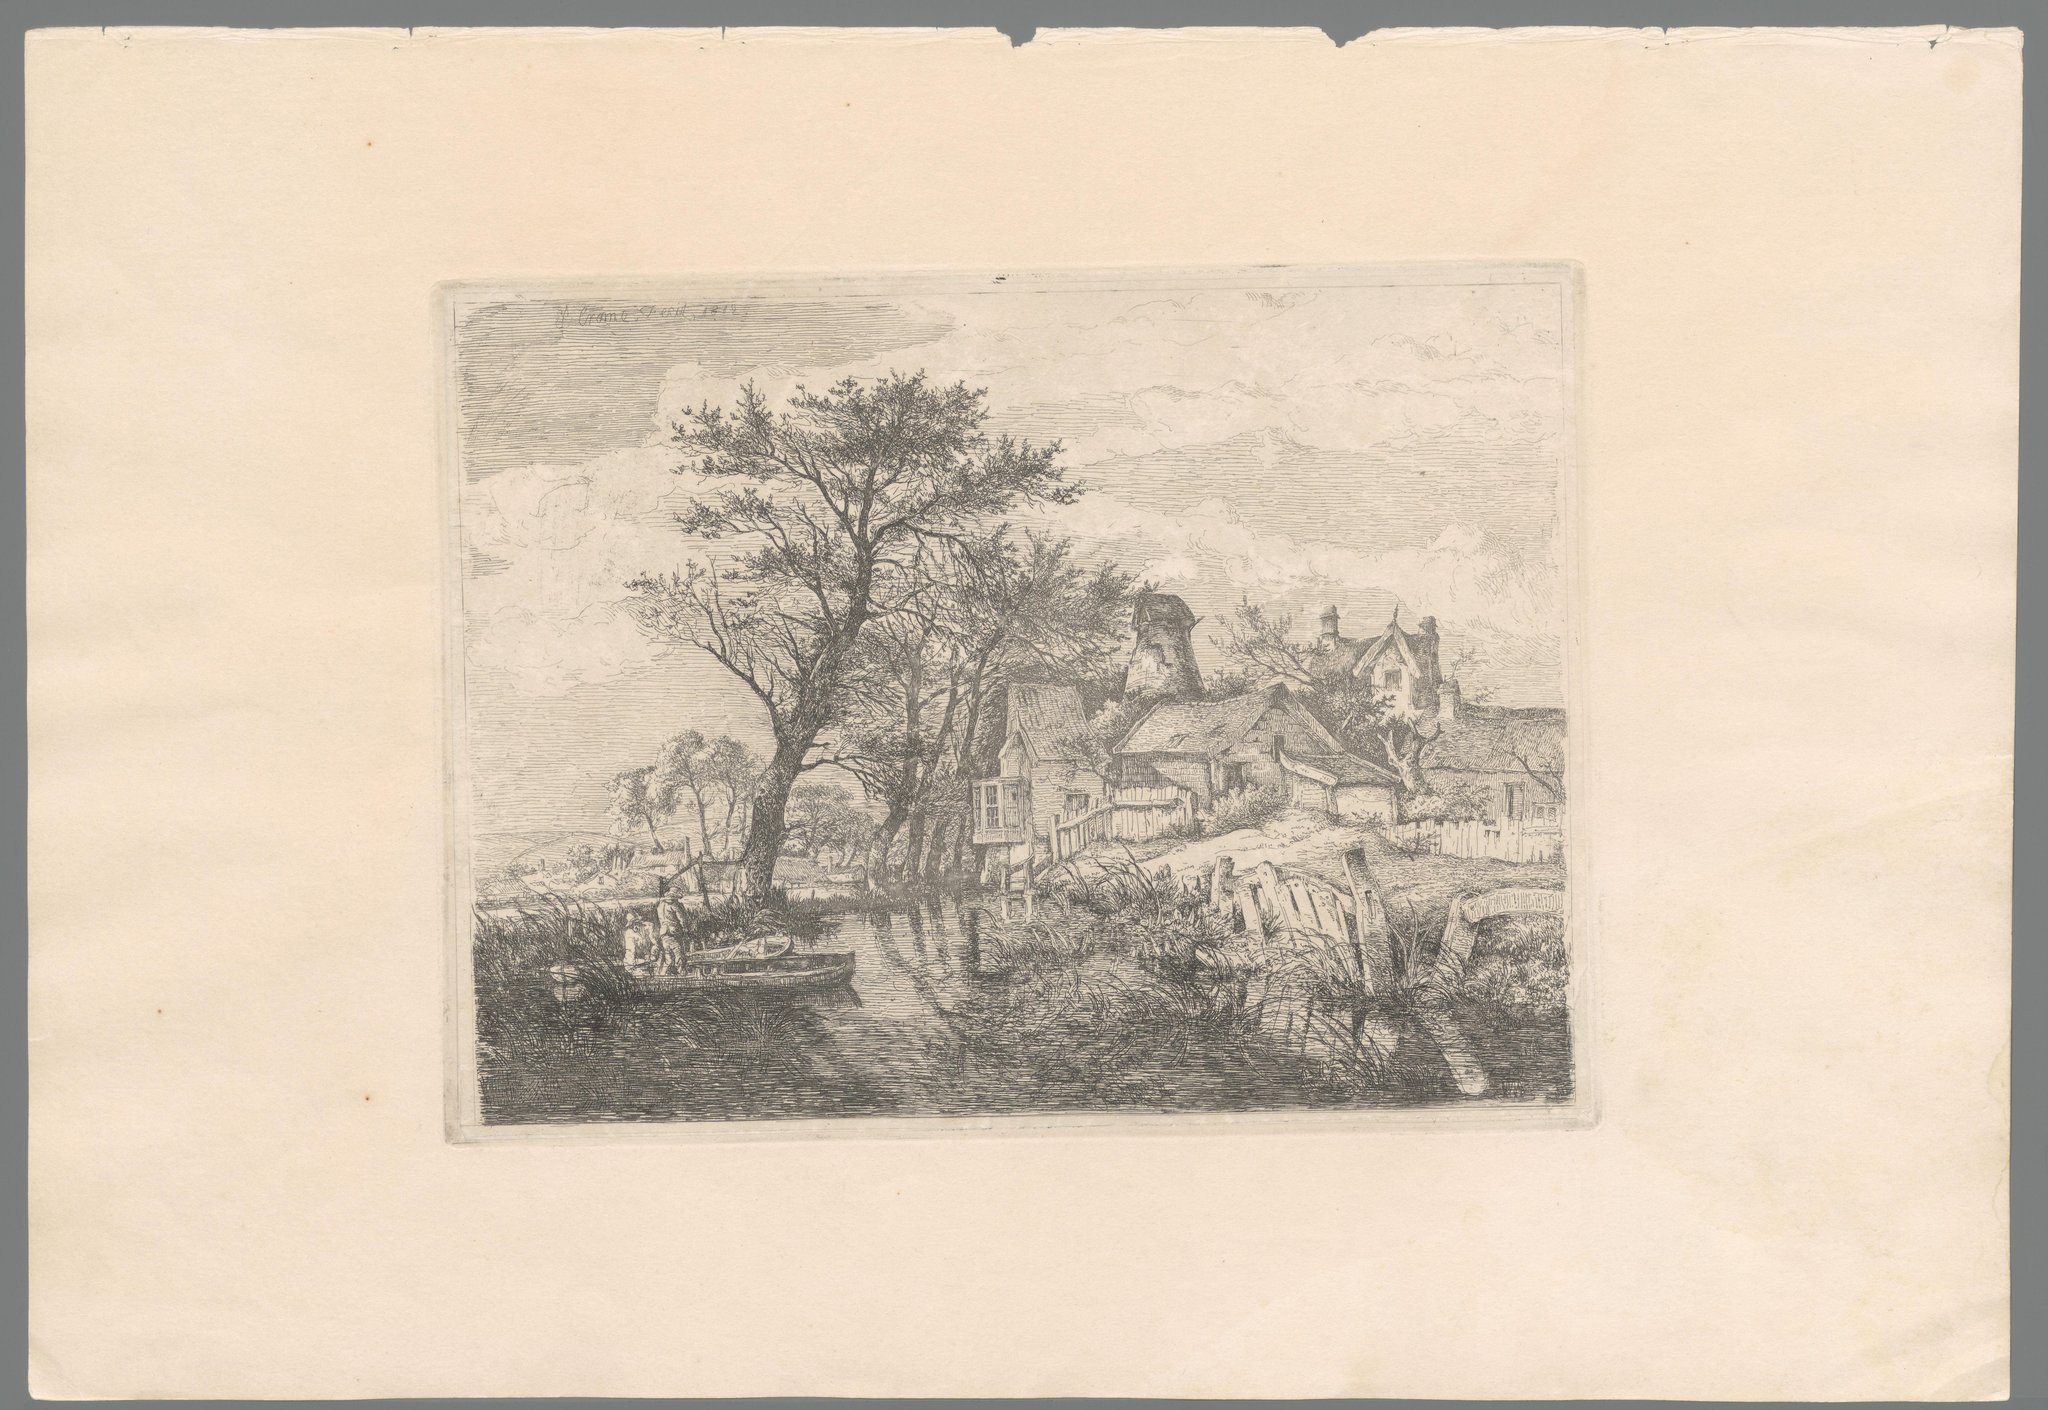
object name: print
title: Twee mannen op boten in een sloot langs een dorp met windmolen zonder wieken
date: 1812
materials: paper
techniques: drypoint, etching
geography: norwich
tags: village, rowing-boat, canoe, etc., windmill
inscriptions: collector's mark: Lugt 2228, collector's mark: Lugt 2760